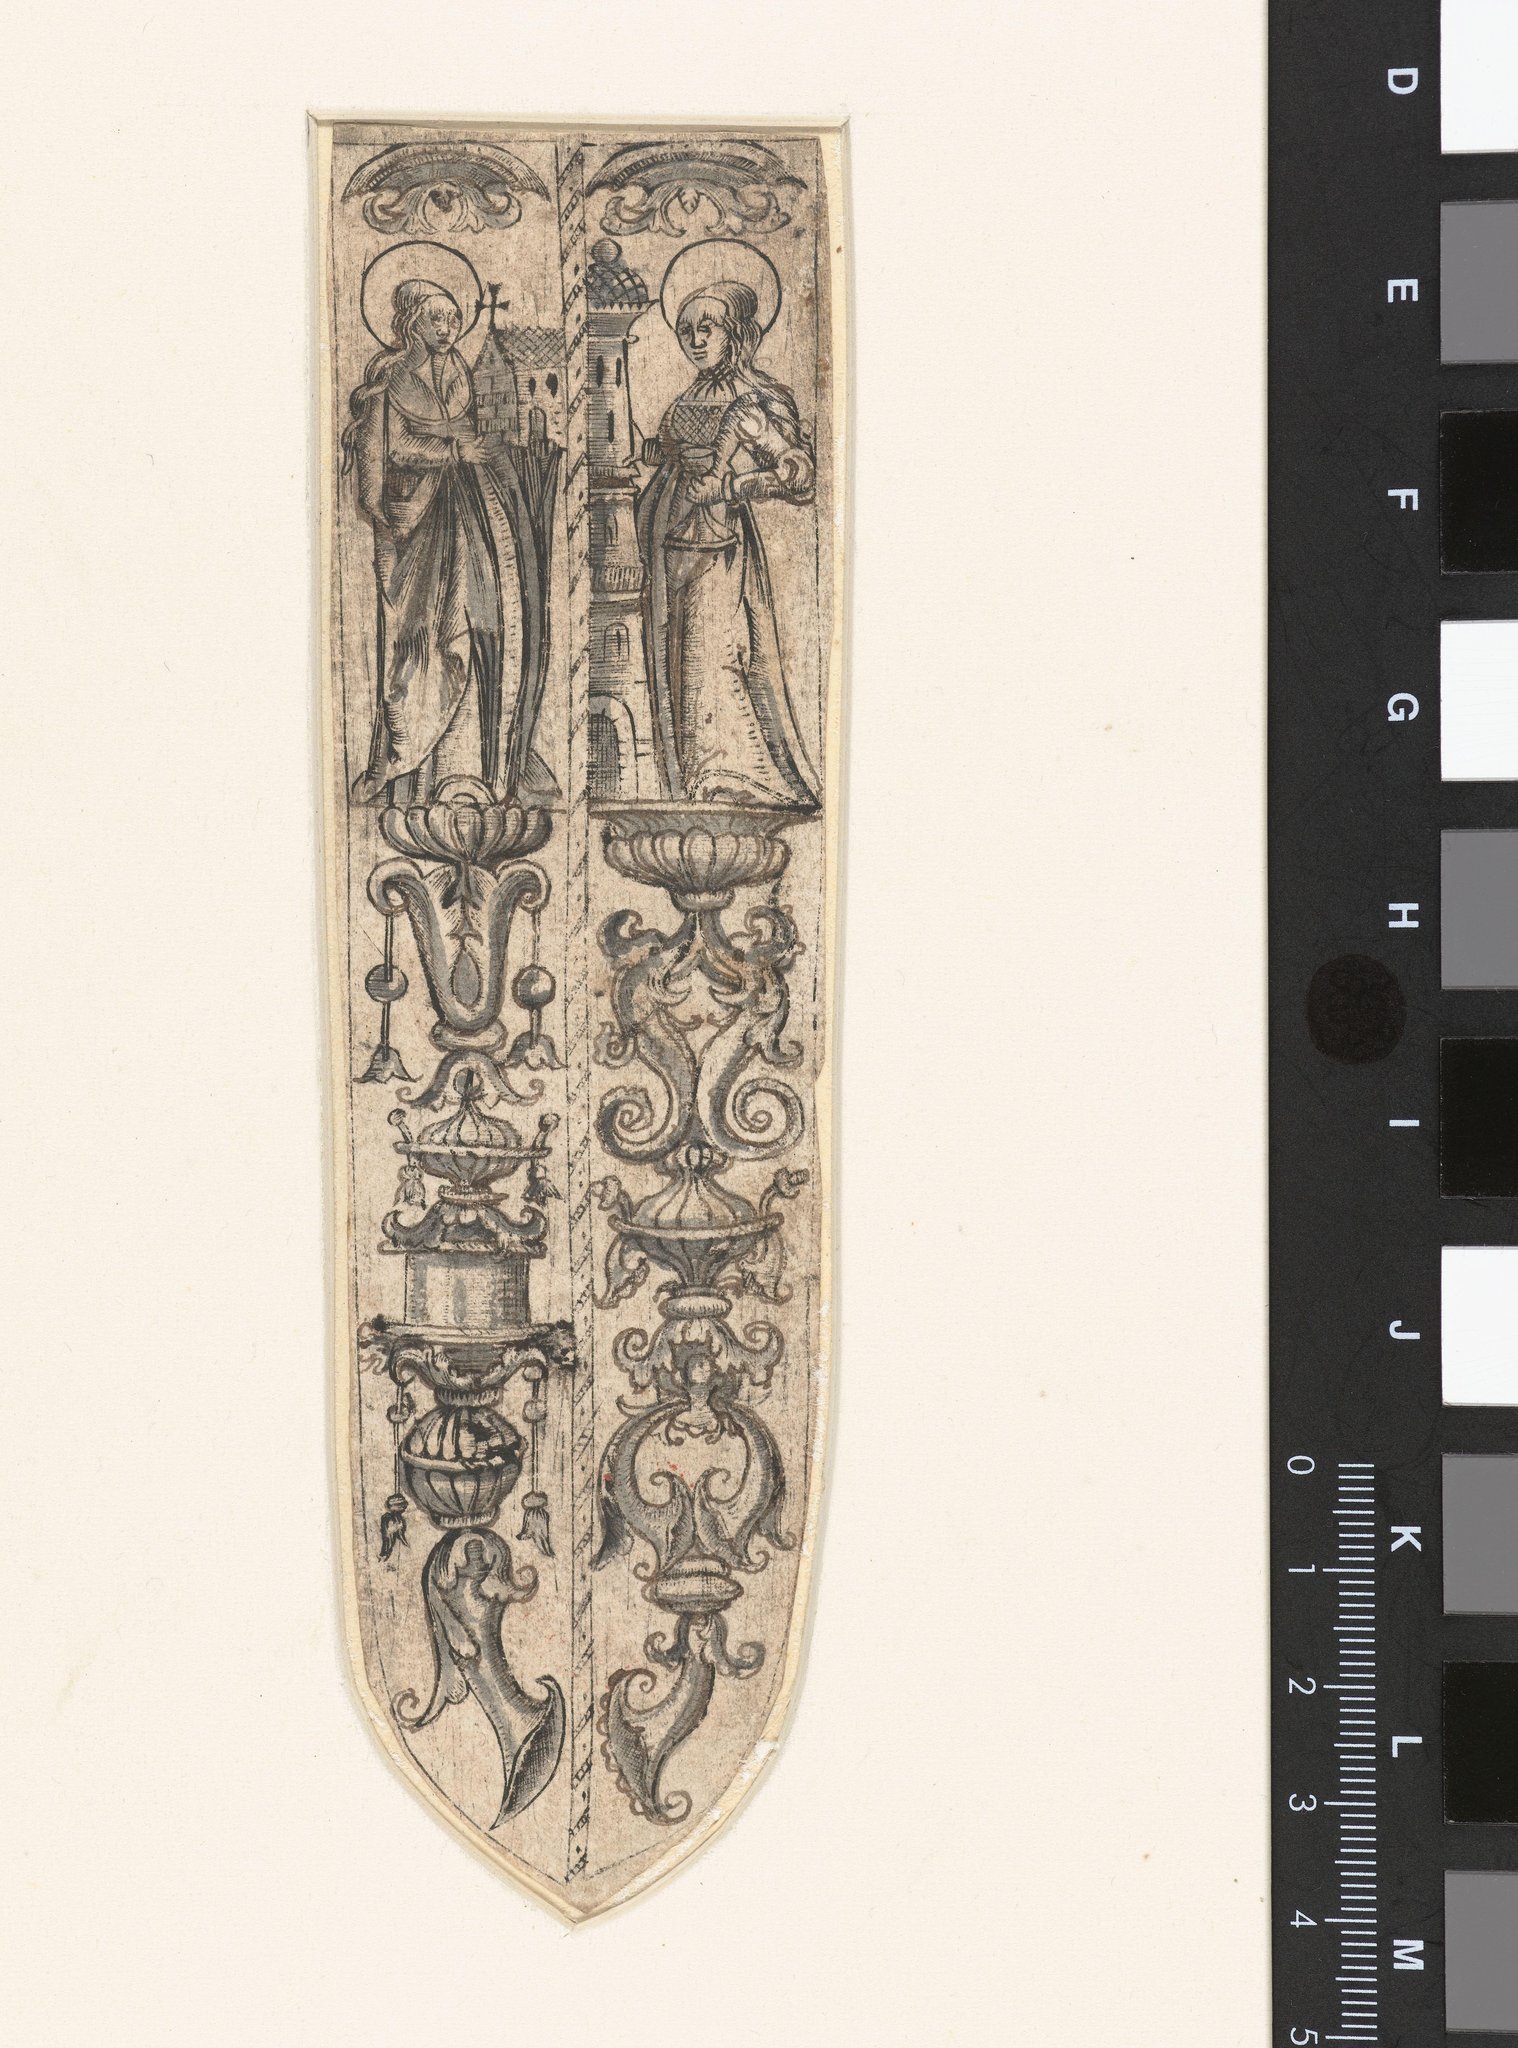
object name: drawing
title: Ontwerp voor een dolkschede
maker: monogrammist as (15e eeuw)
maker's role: draughtsman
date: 1400-1500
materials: ink, paper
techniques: brush, pen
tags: the virgin martyr barbara; possible attributes: book, cannon(ball), crown, cross, chalice with wafer, dioscuros (her father), peacock feather, sword, torches, mason's tools, tower, scabbard, sheath, female saints